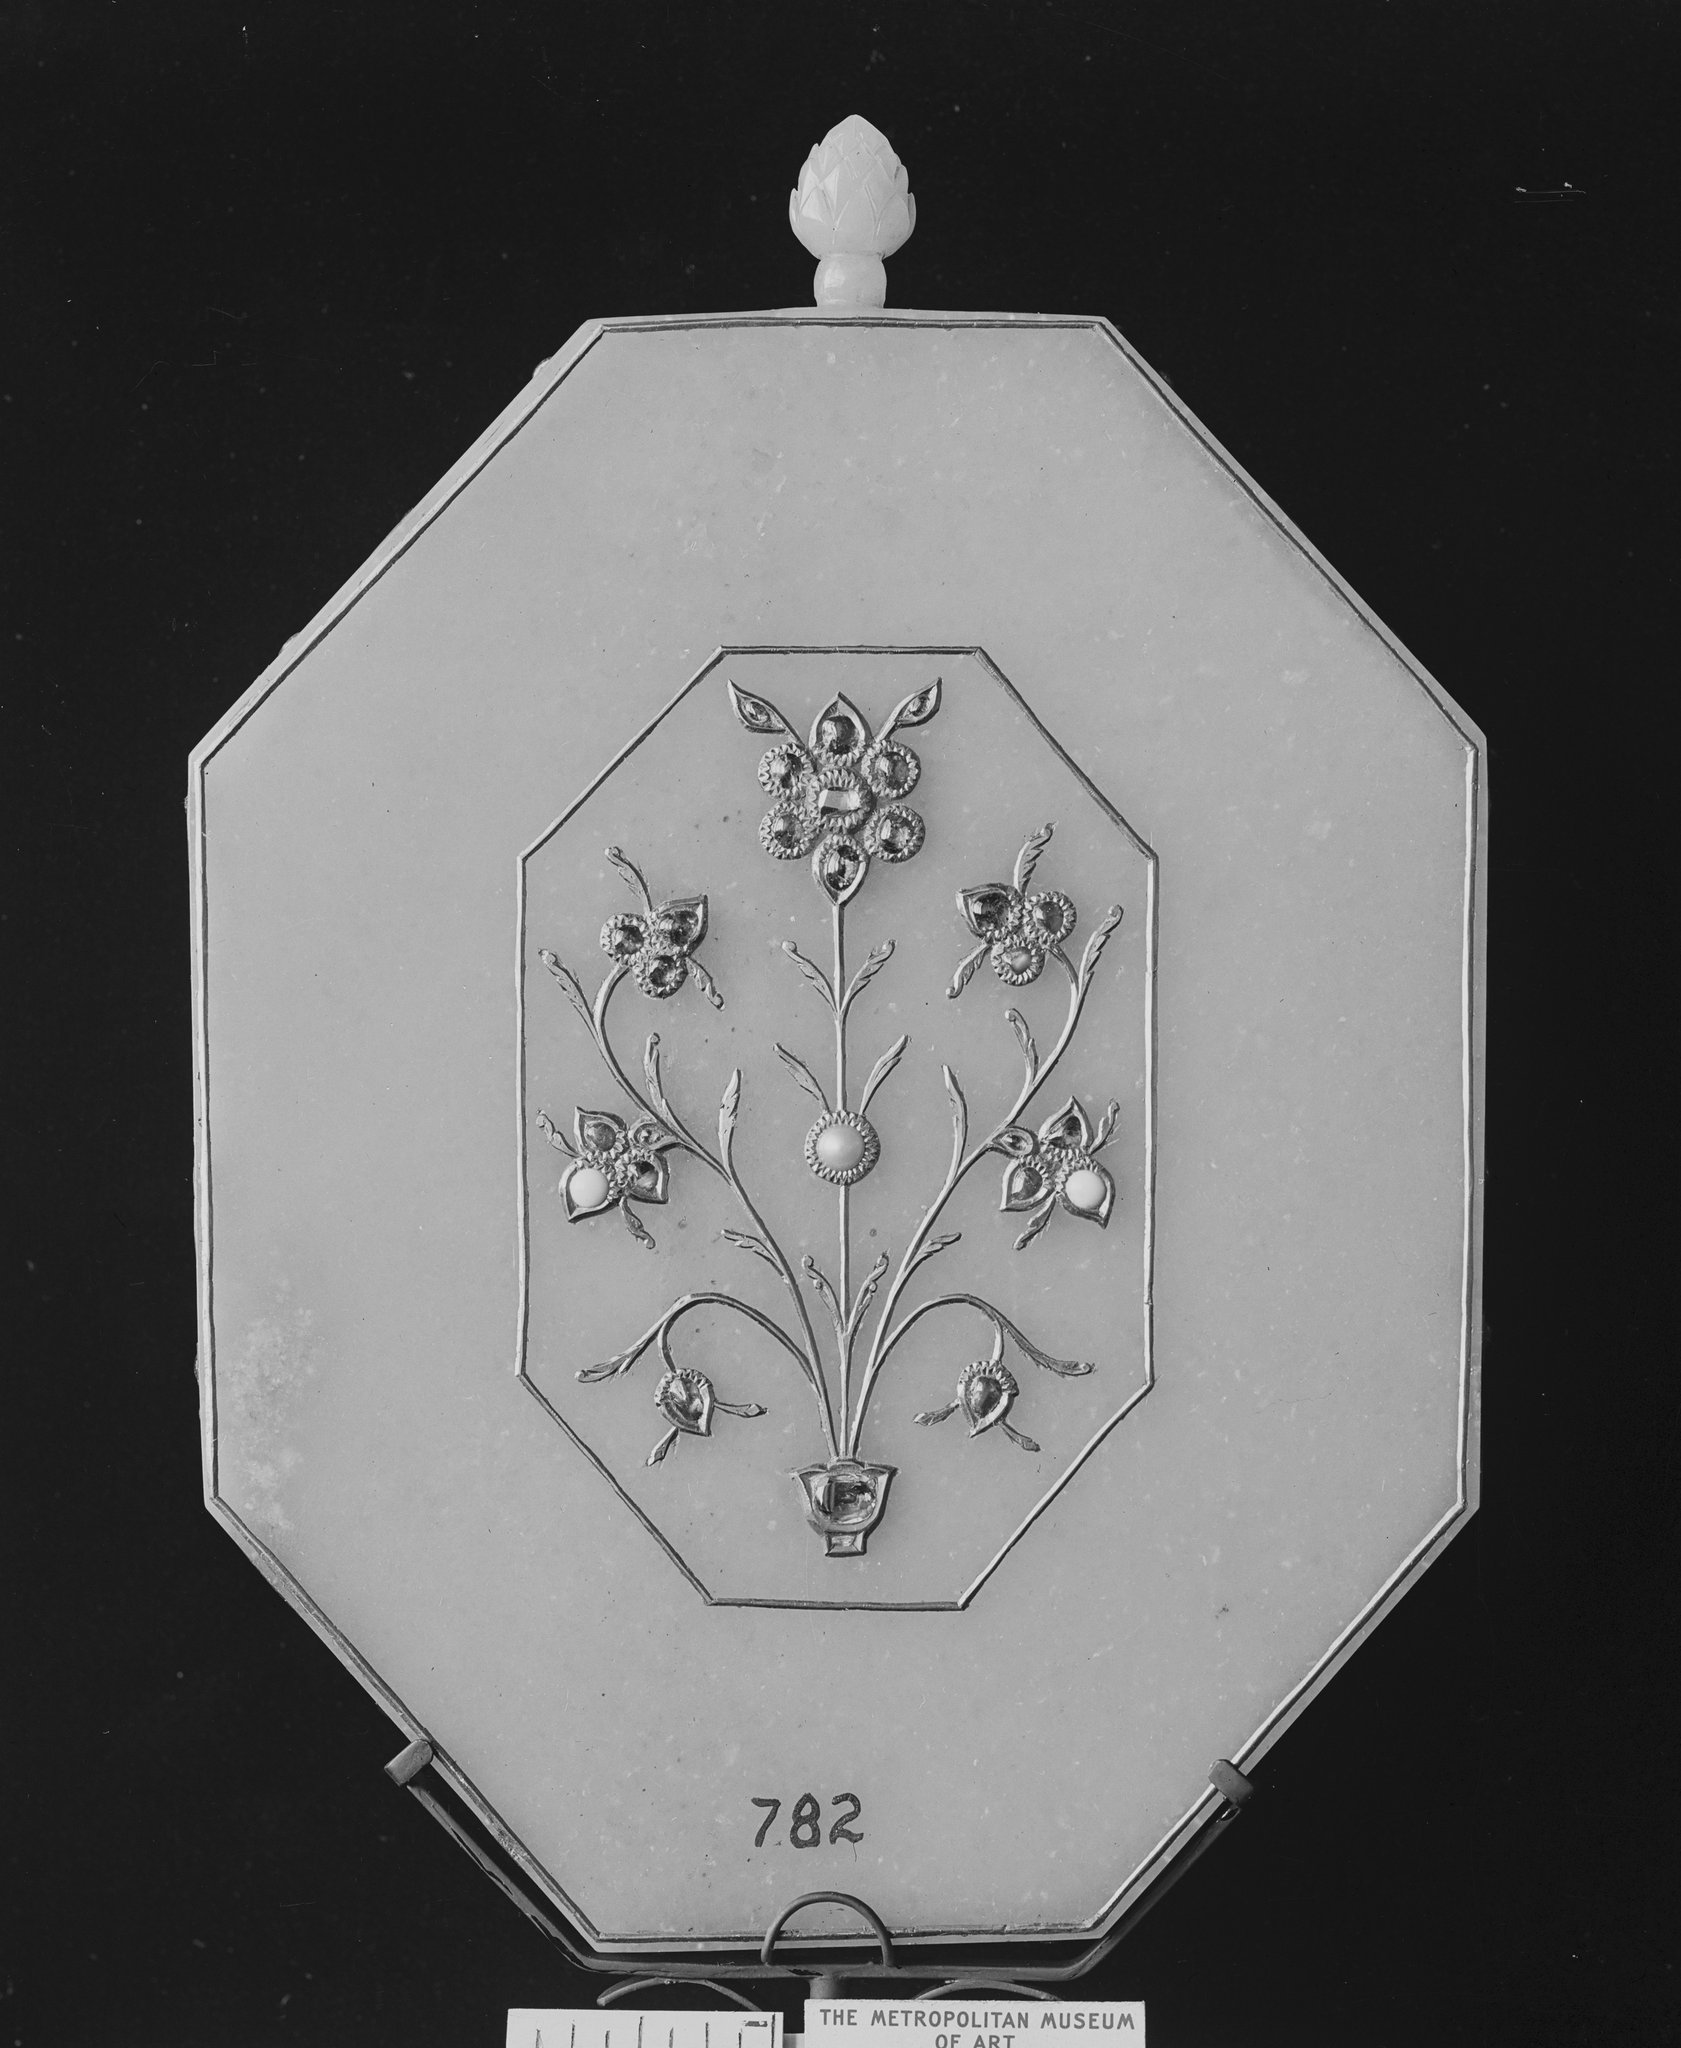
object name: mirror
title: Jewelled Mirror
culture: indian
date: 1801-1900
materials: jade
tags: flowers